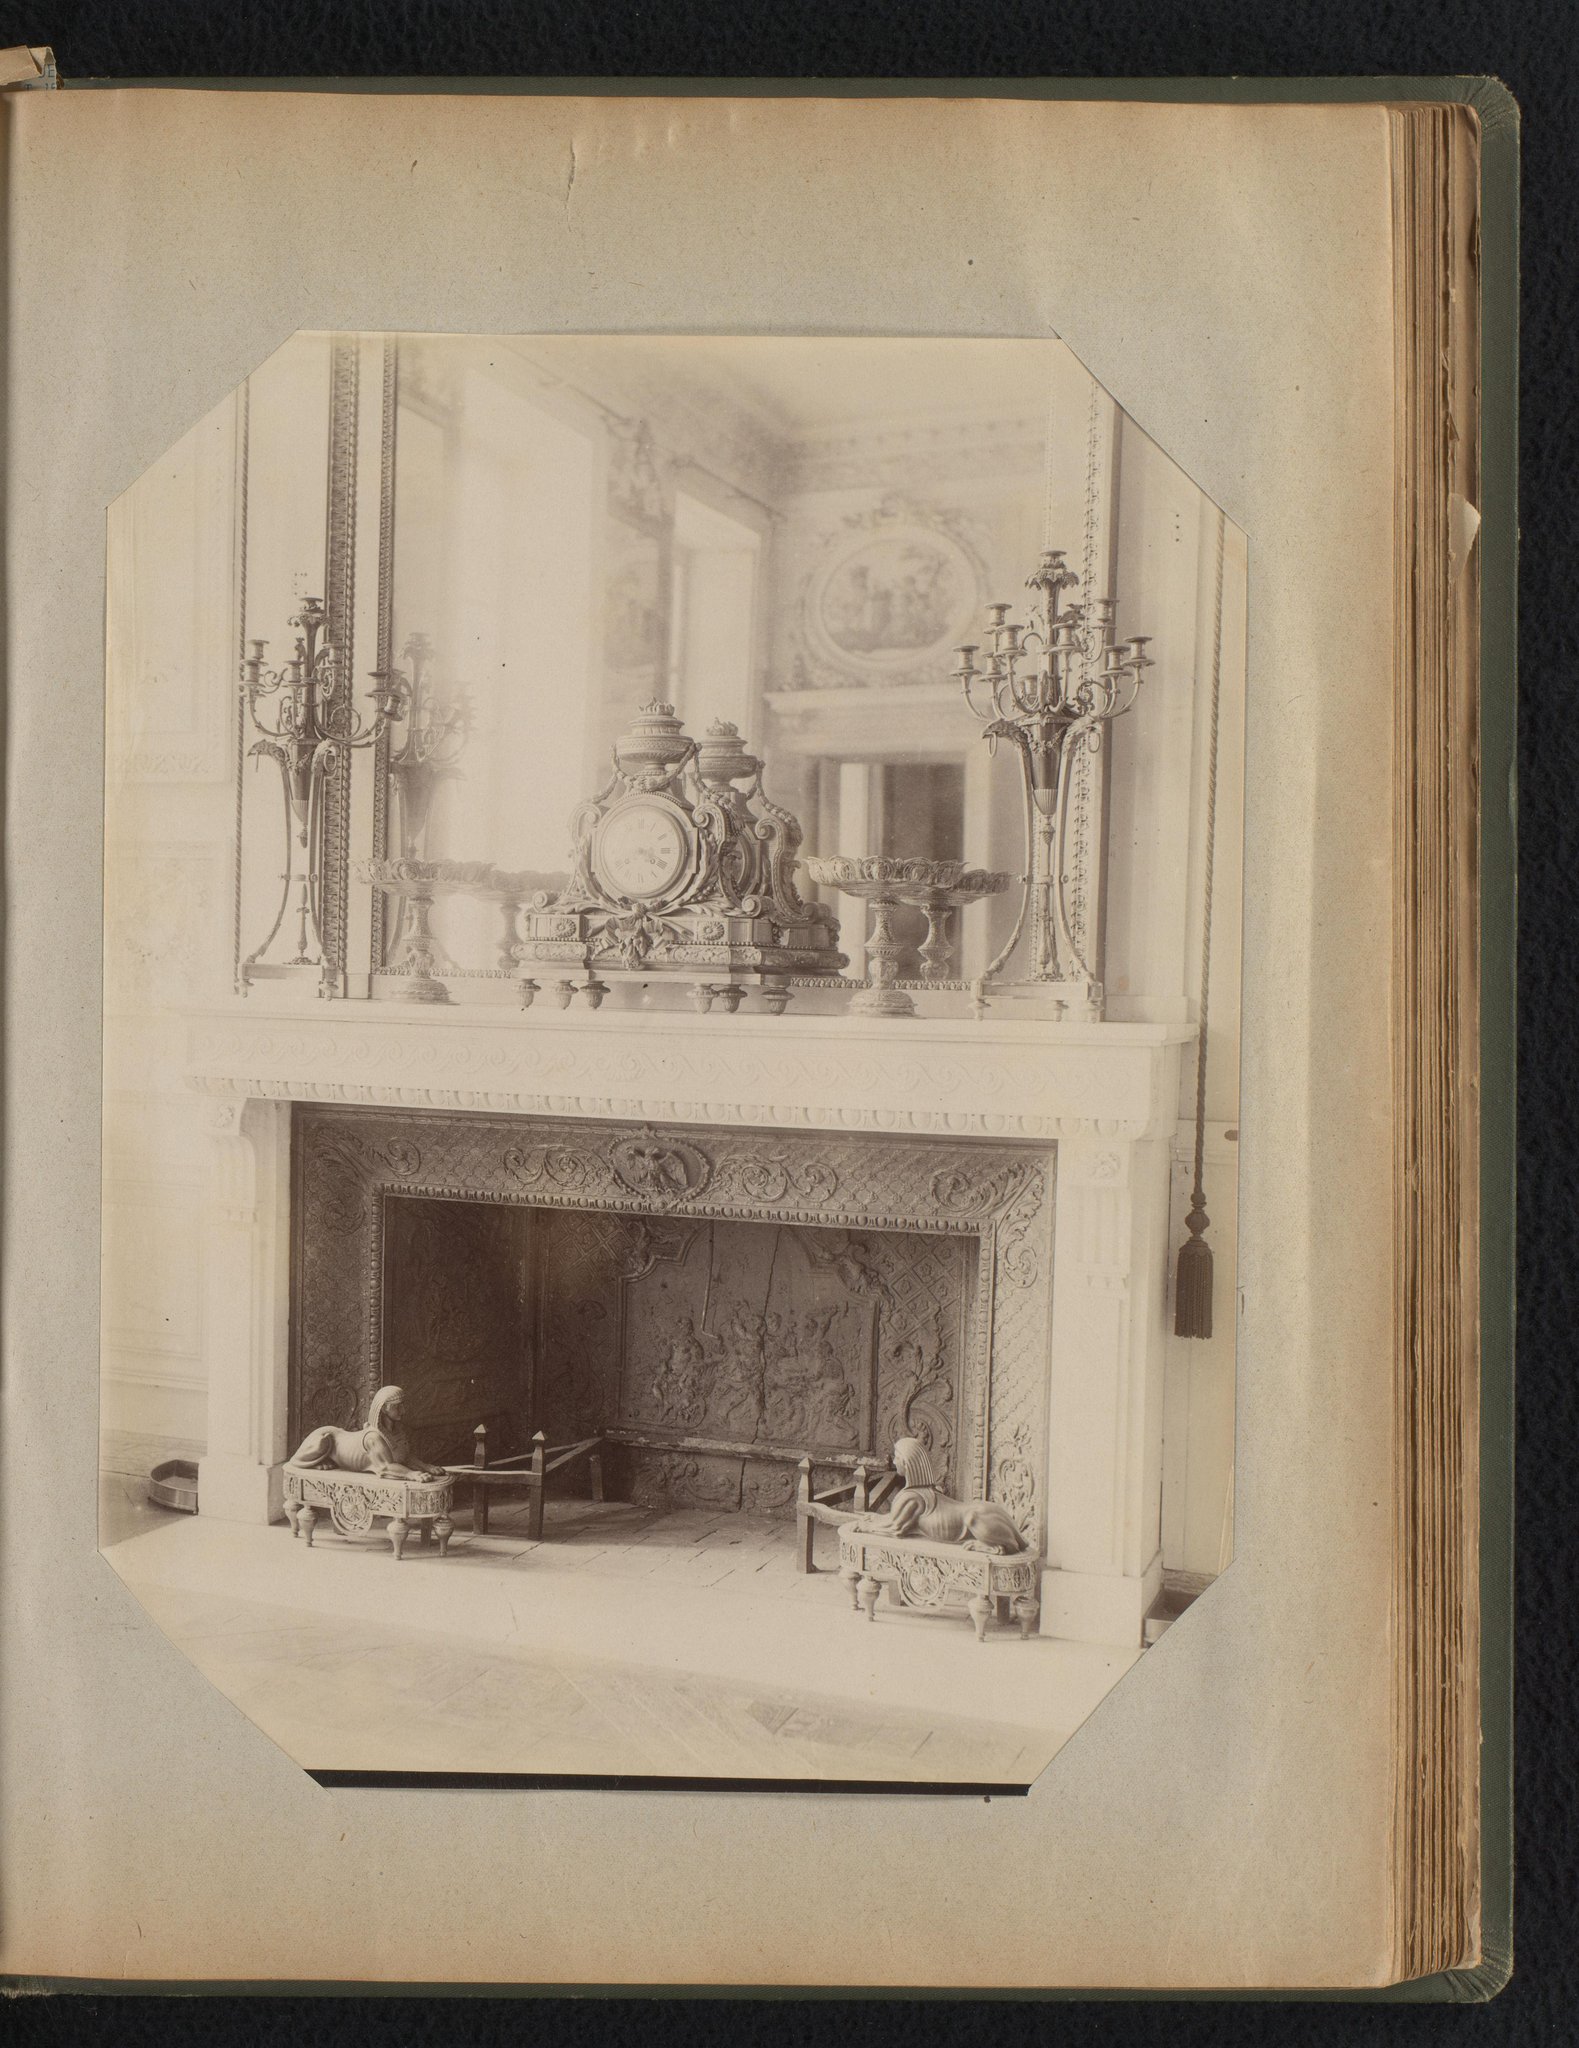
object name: photograph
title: Bronzen mantelstuk bestaande uit een klok met kransen, twee schalen en twee achtarmige kandelaars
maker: Anonymous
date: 1860-1900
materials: canvas, cardboard, paper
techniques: albumen print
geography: netherlands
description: Bronzen mantelstuk bestaande uit een gedecoreerde klok met kransen, twee schalen en twee achtarmige kandelaars voorzien van havikskoppen. Op de grond staan twee bronzen sfinxen op een voetstuk. De foto is onderdeel van een serie met betrekking tot het interieur van het paleis van Versailles met kroonluchters, deuren, portalen en meubelstukken.